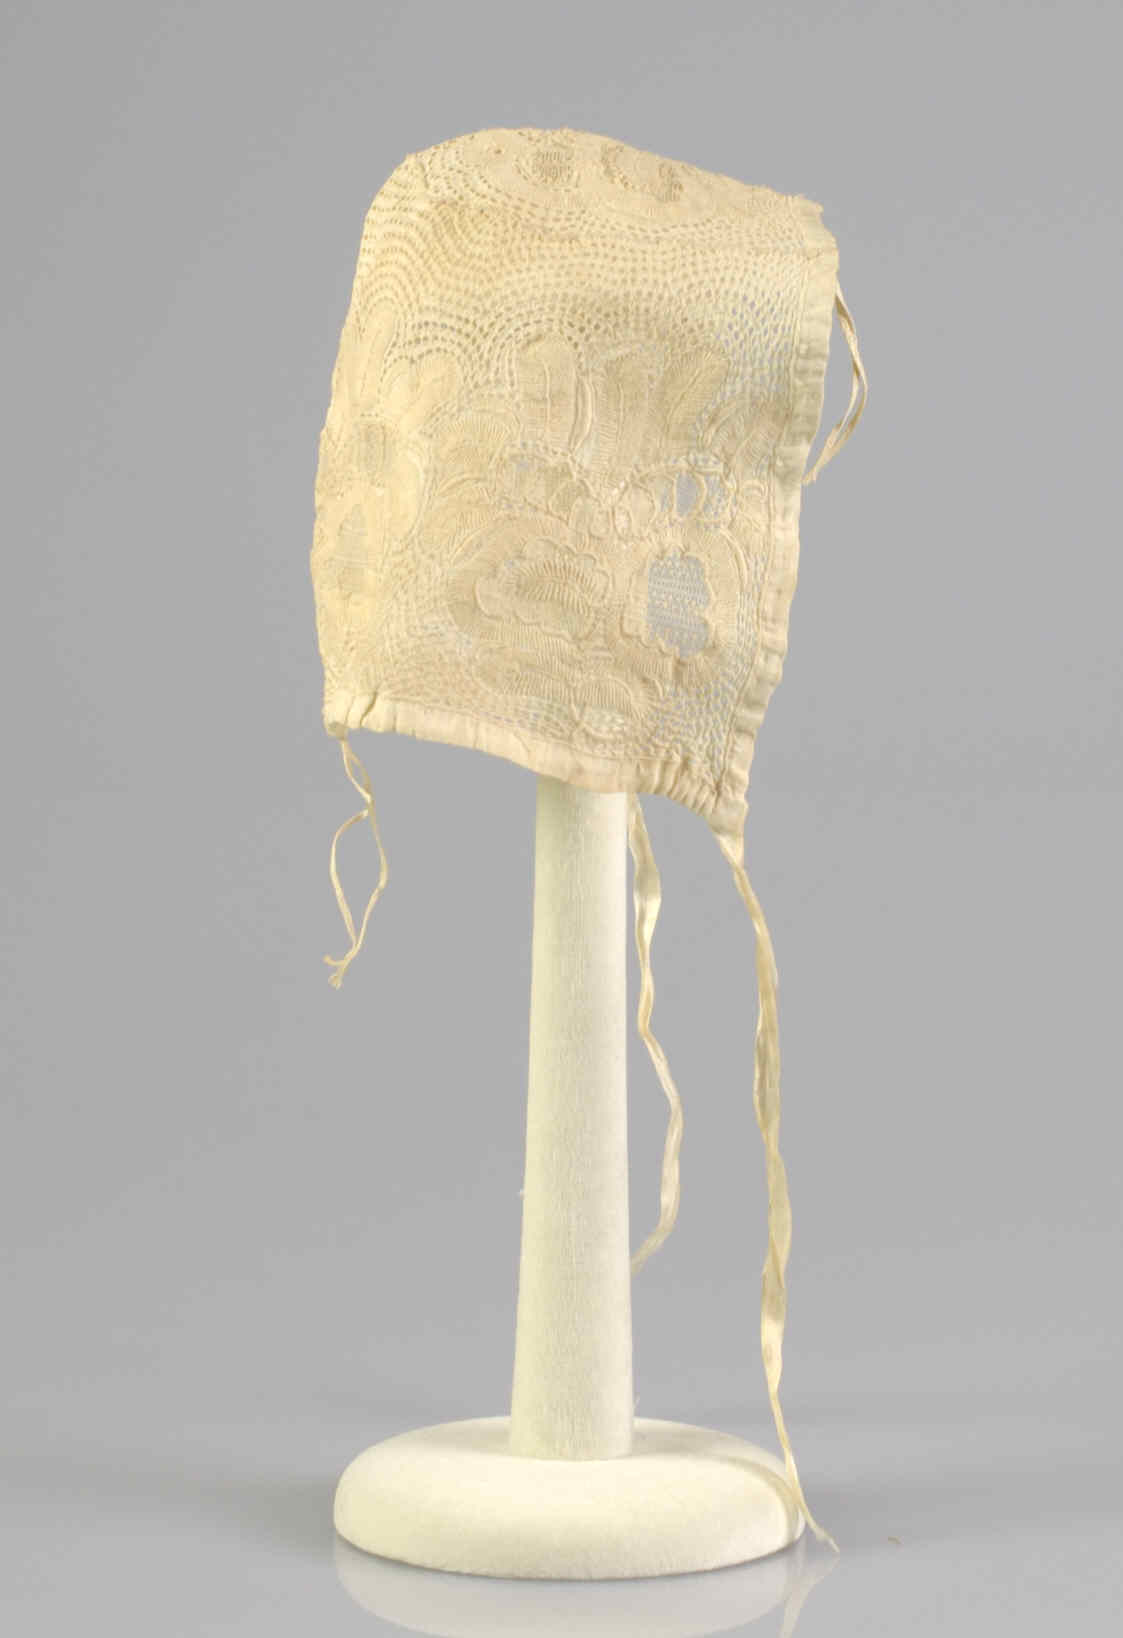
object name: cap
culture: american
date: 1830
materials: cotton